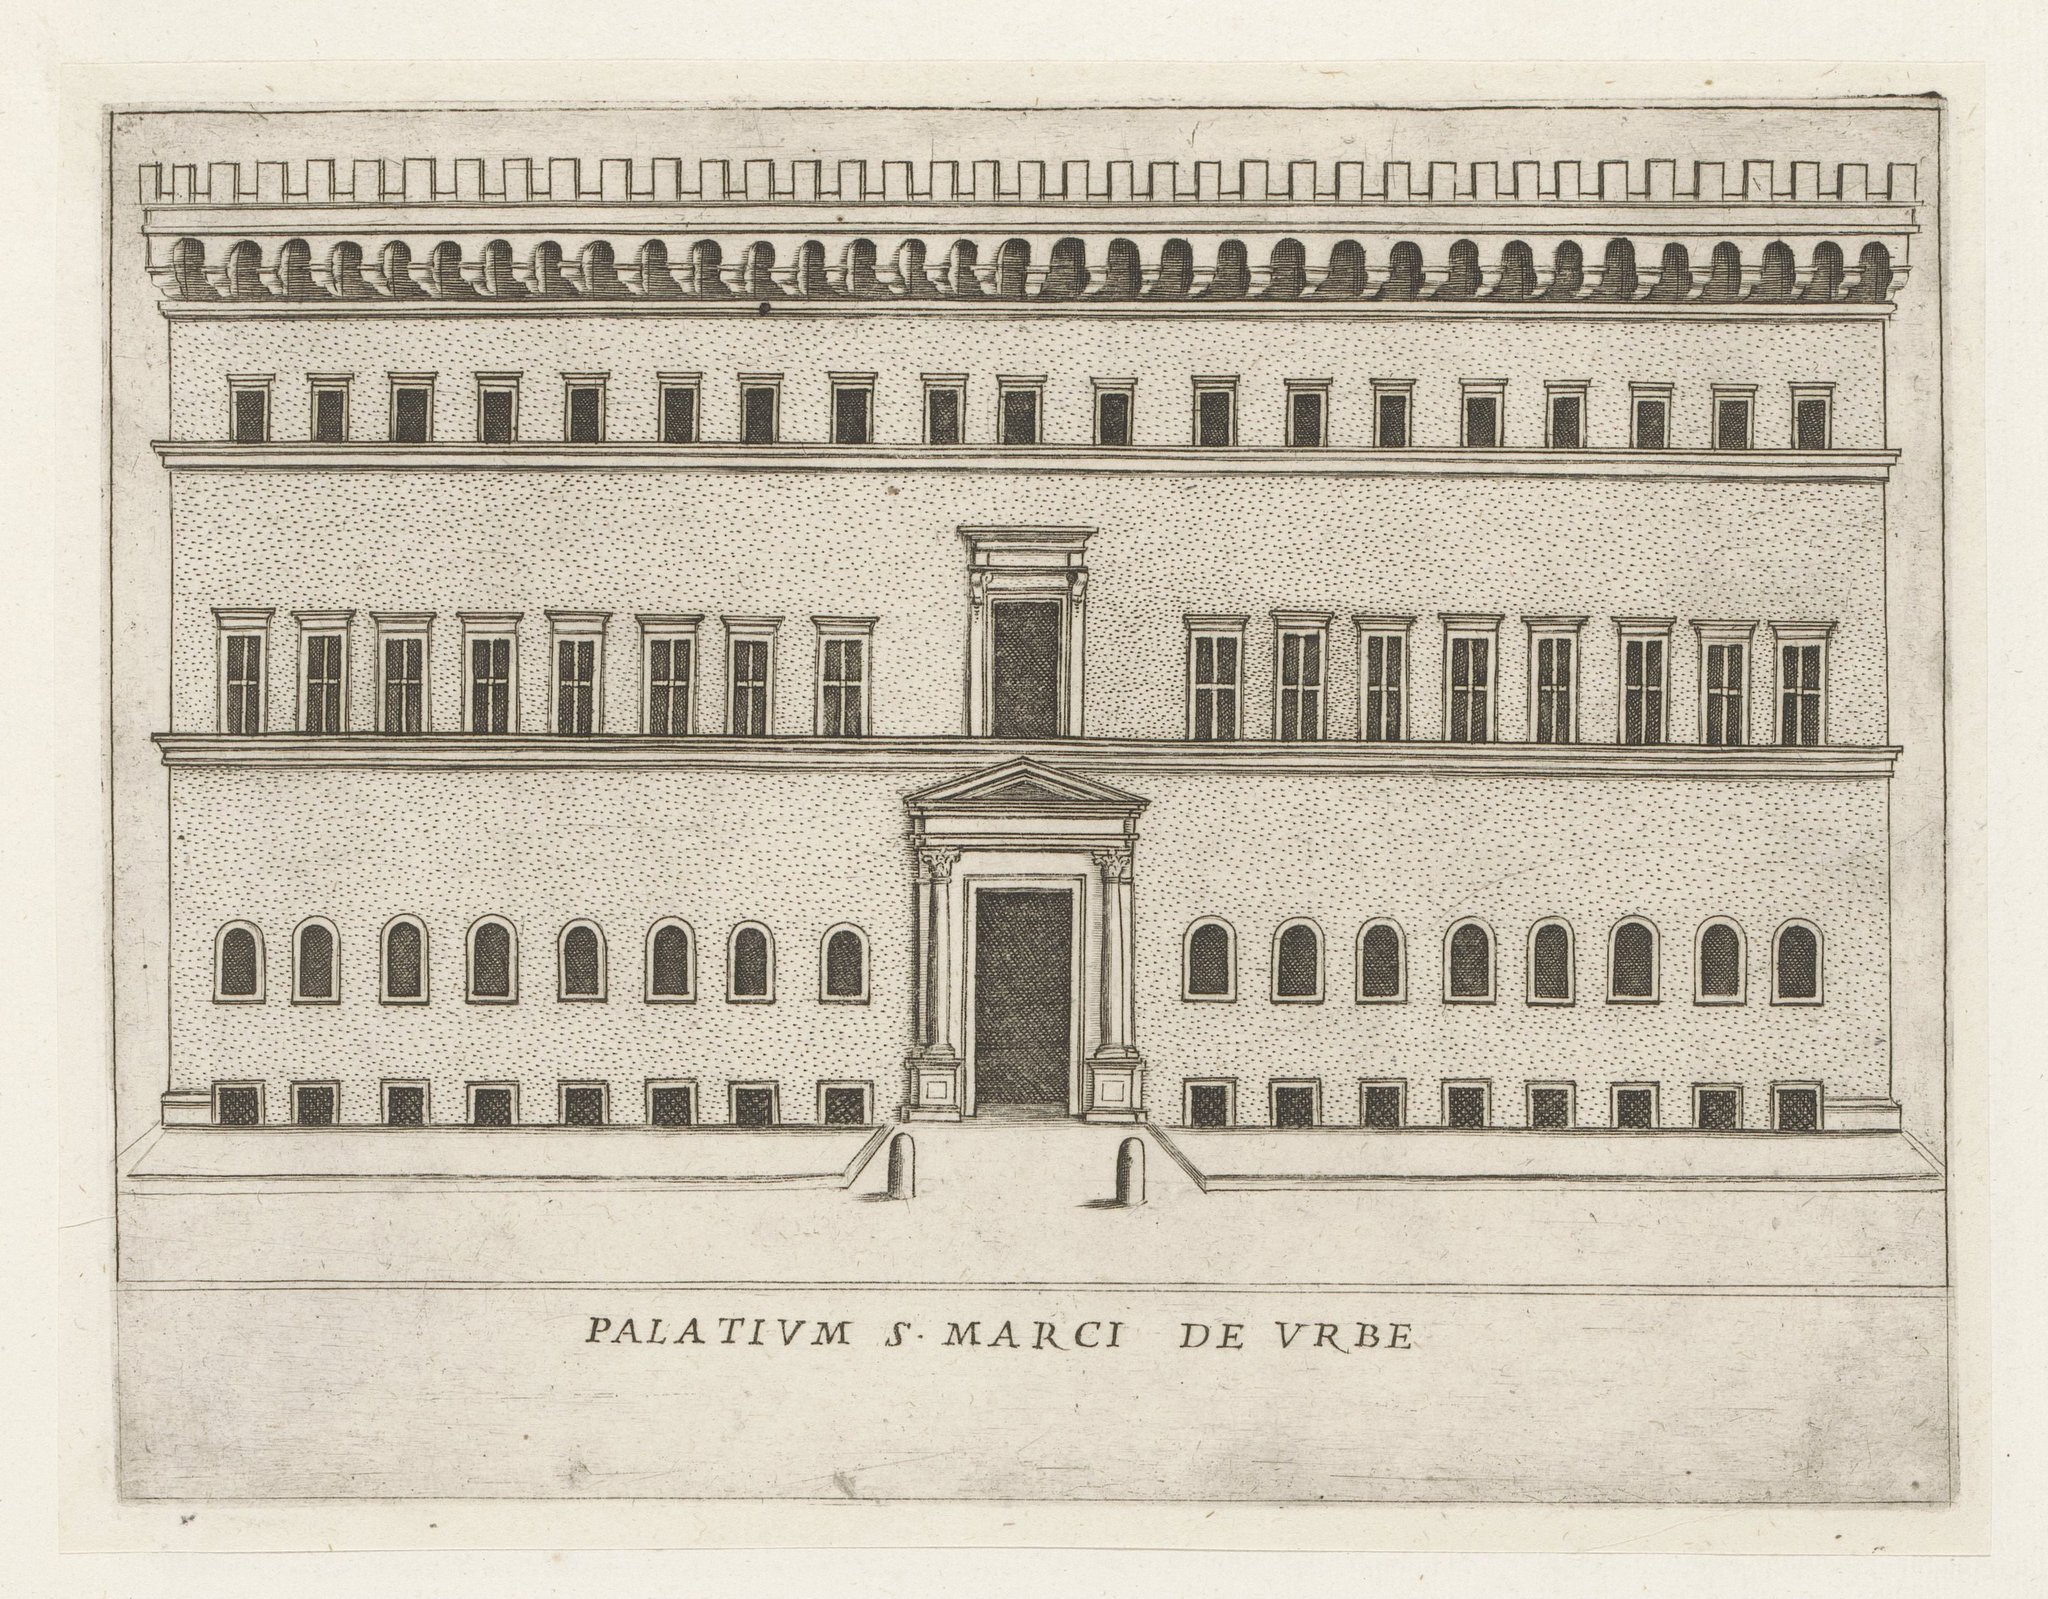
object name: album leaf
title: Façade van Palazzo Venezia te Rome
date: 1638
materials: paper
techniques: etching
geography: rome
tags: hôtel, i.e. small palace in city, façade (of house or building)